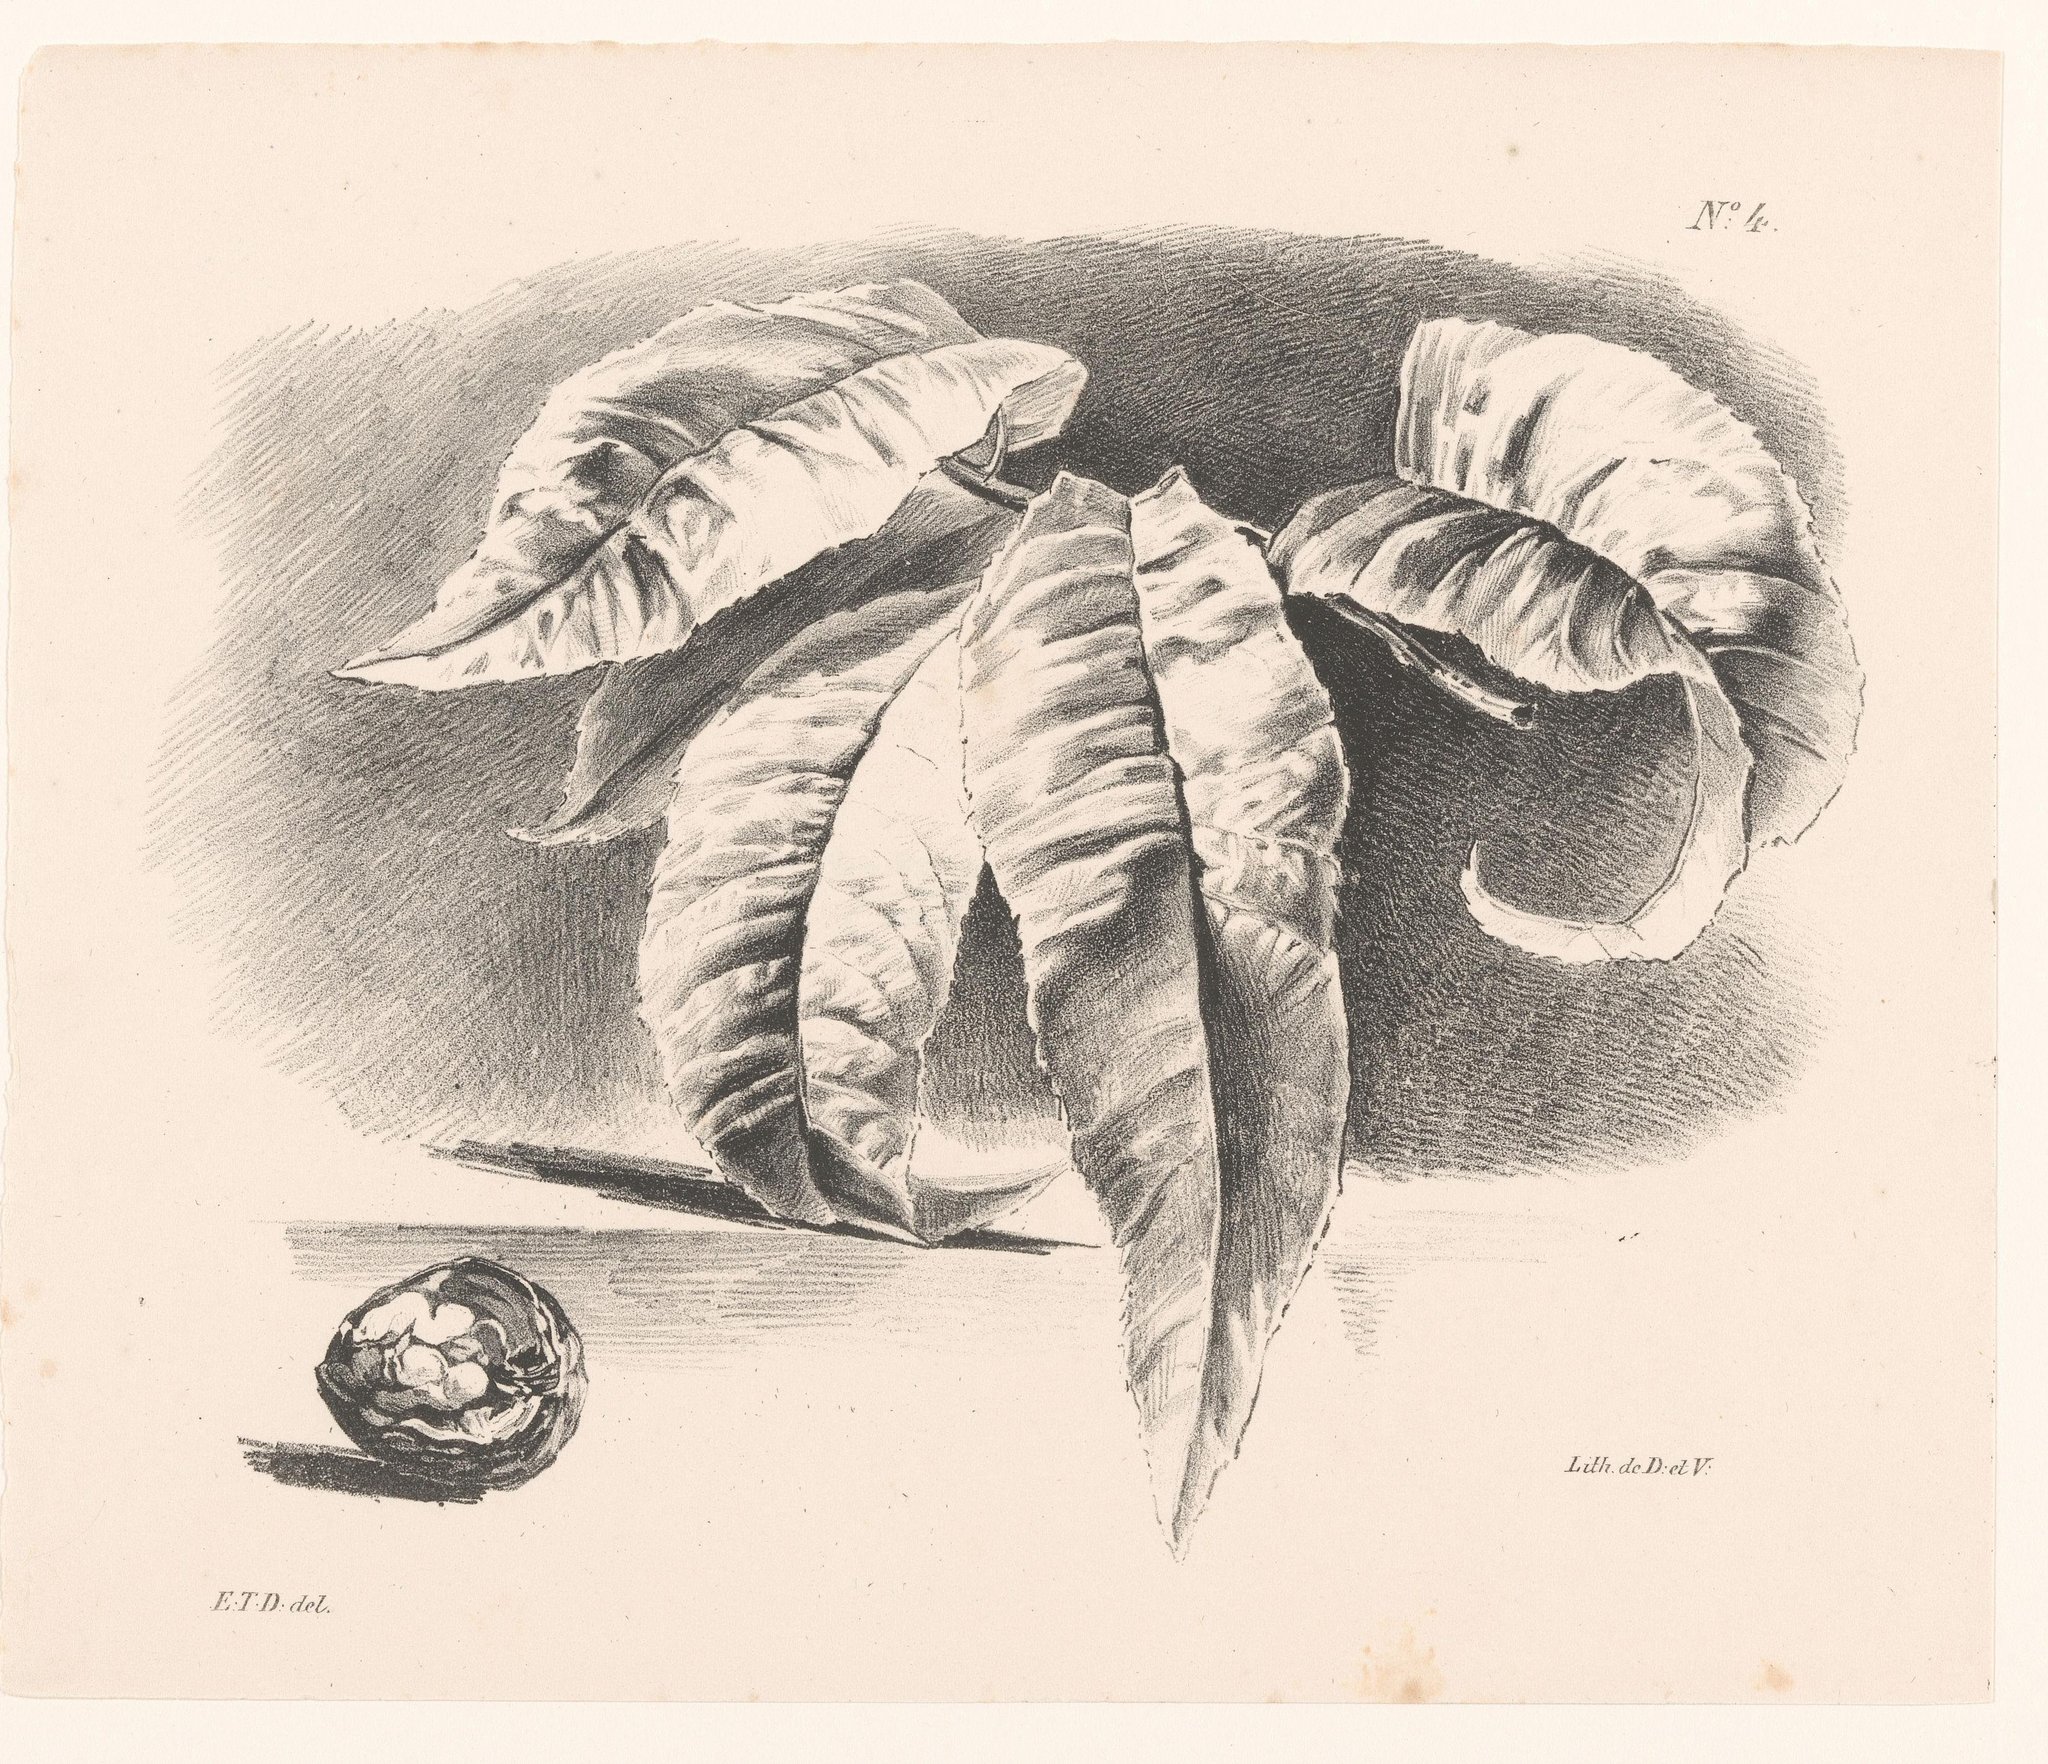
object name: print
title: Bladeren en walnoot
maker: elise therèse daiwaille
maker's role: print maker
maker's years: 1814-1881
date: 1824-1881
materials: paper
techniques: lithograph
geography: amsterdam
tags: trees: walnut-tree (+ leaf), fruits: walnut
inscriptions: collector's mark: Lugt 2228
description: De bladeren zitten aan een tak, de walnoot is opengebroken. Genummerd rechtsboven: 'No. 4'. De prent maakt deel uit van een omslag met zes prenten.